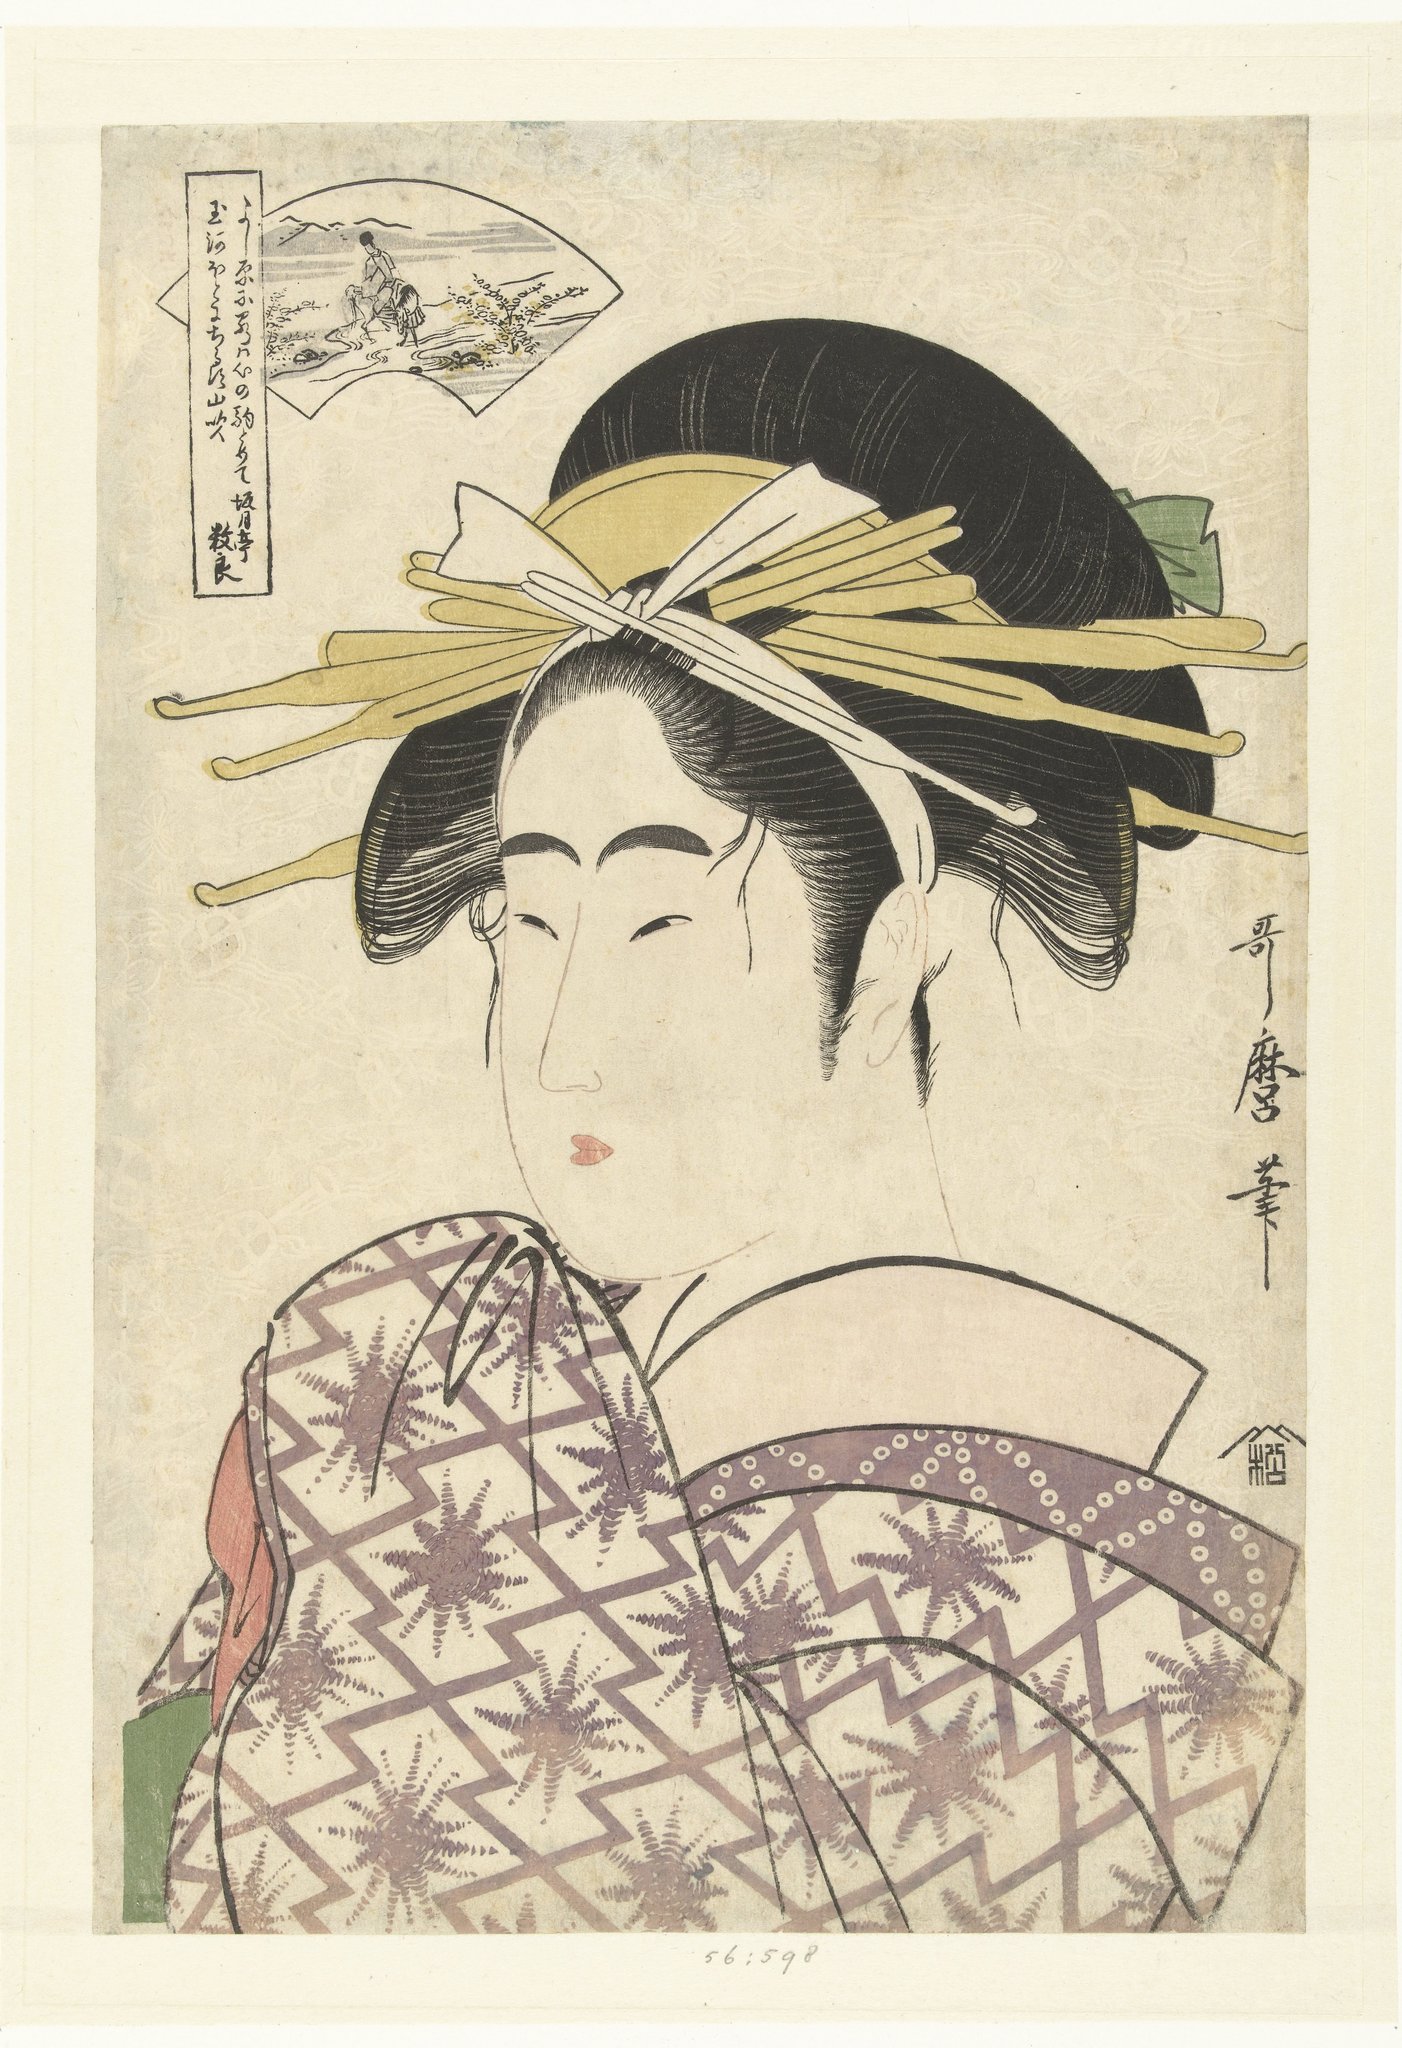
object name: print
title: Courtisane en de Ide Tama rivier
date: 1795-1800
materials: paper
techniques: blind stamped, woodcut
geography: japan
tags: river, historical persons - bb - woman, courtesan, hetaera